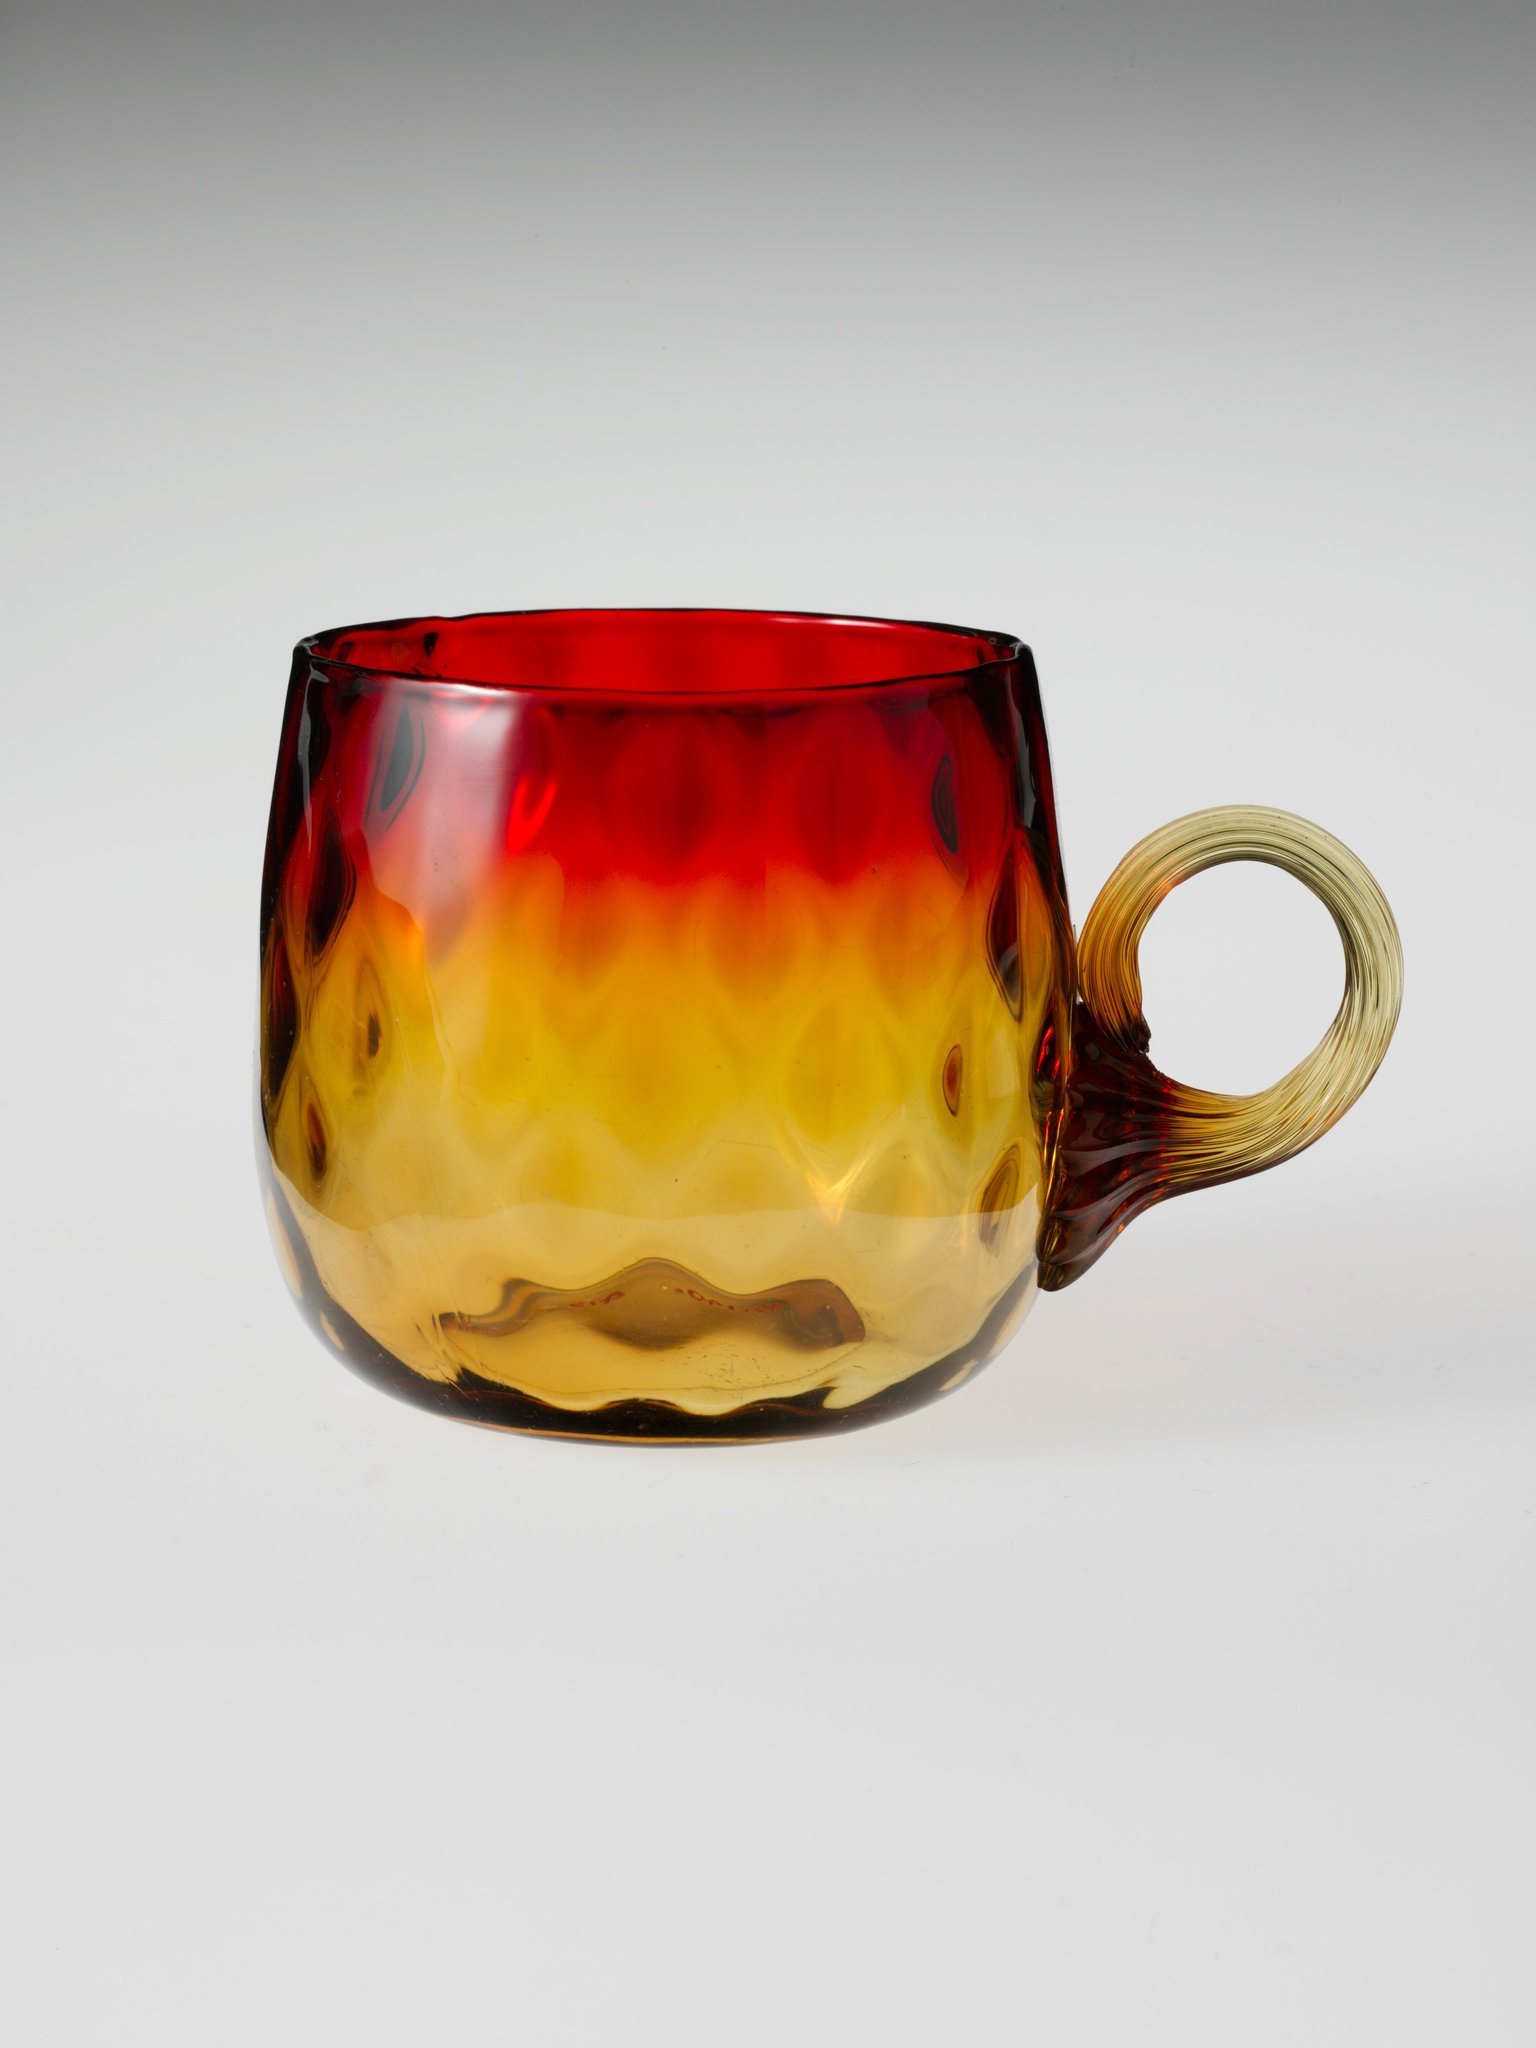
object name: cup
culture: american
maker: new england glass company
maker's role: maker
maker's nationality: american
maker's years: 1818-1888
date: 1801-1900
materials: glass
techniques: glassblowing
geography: united states